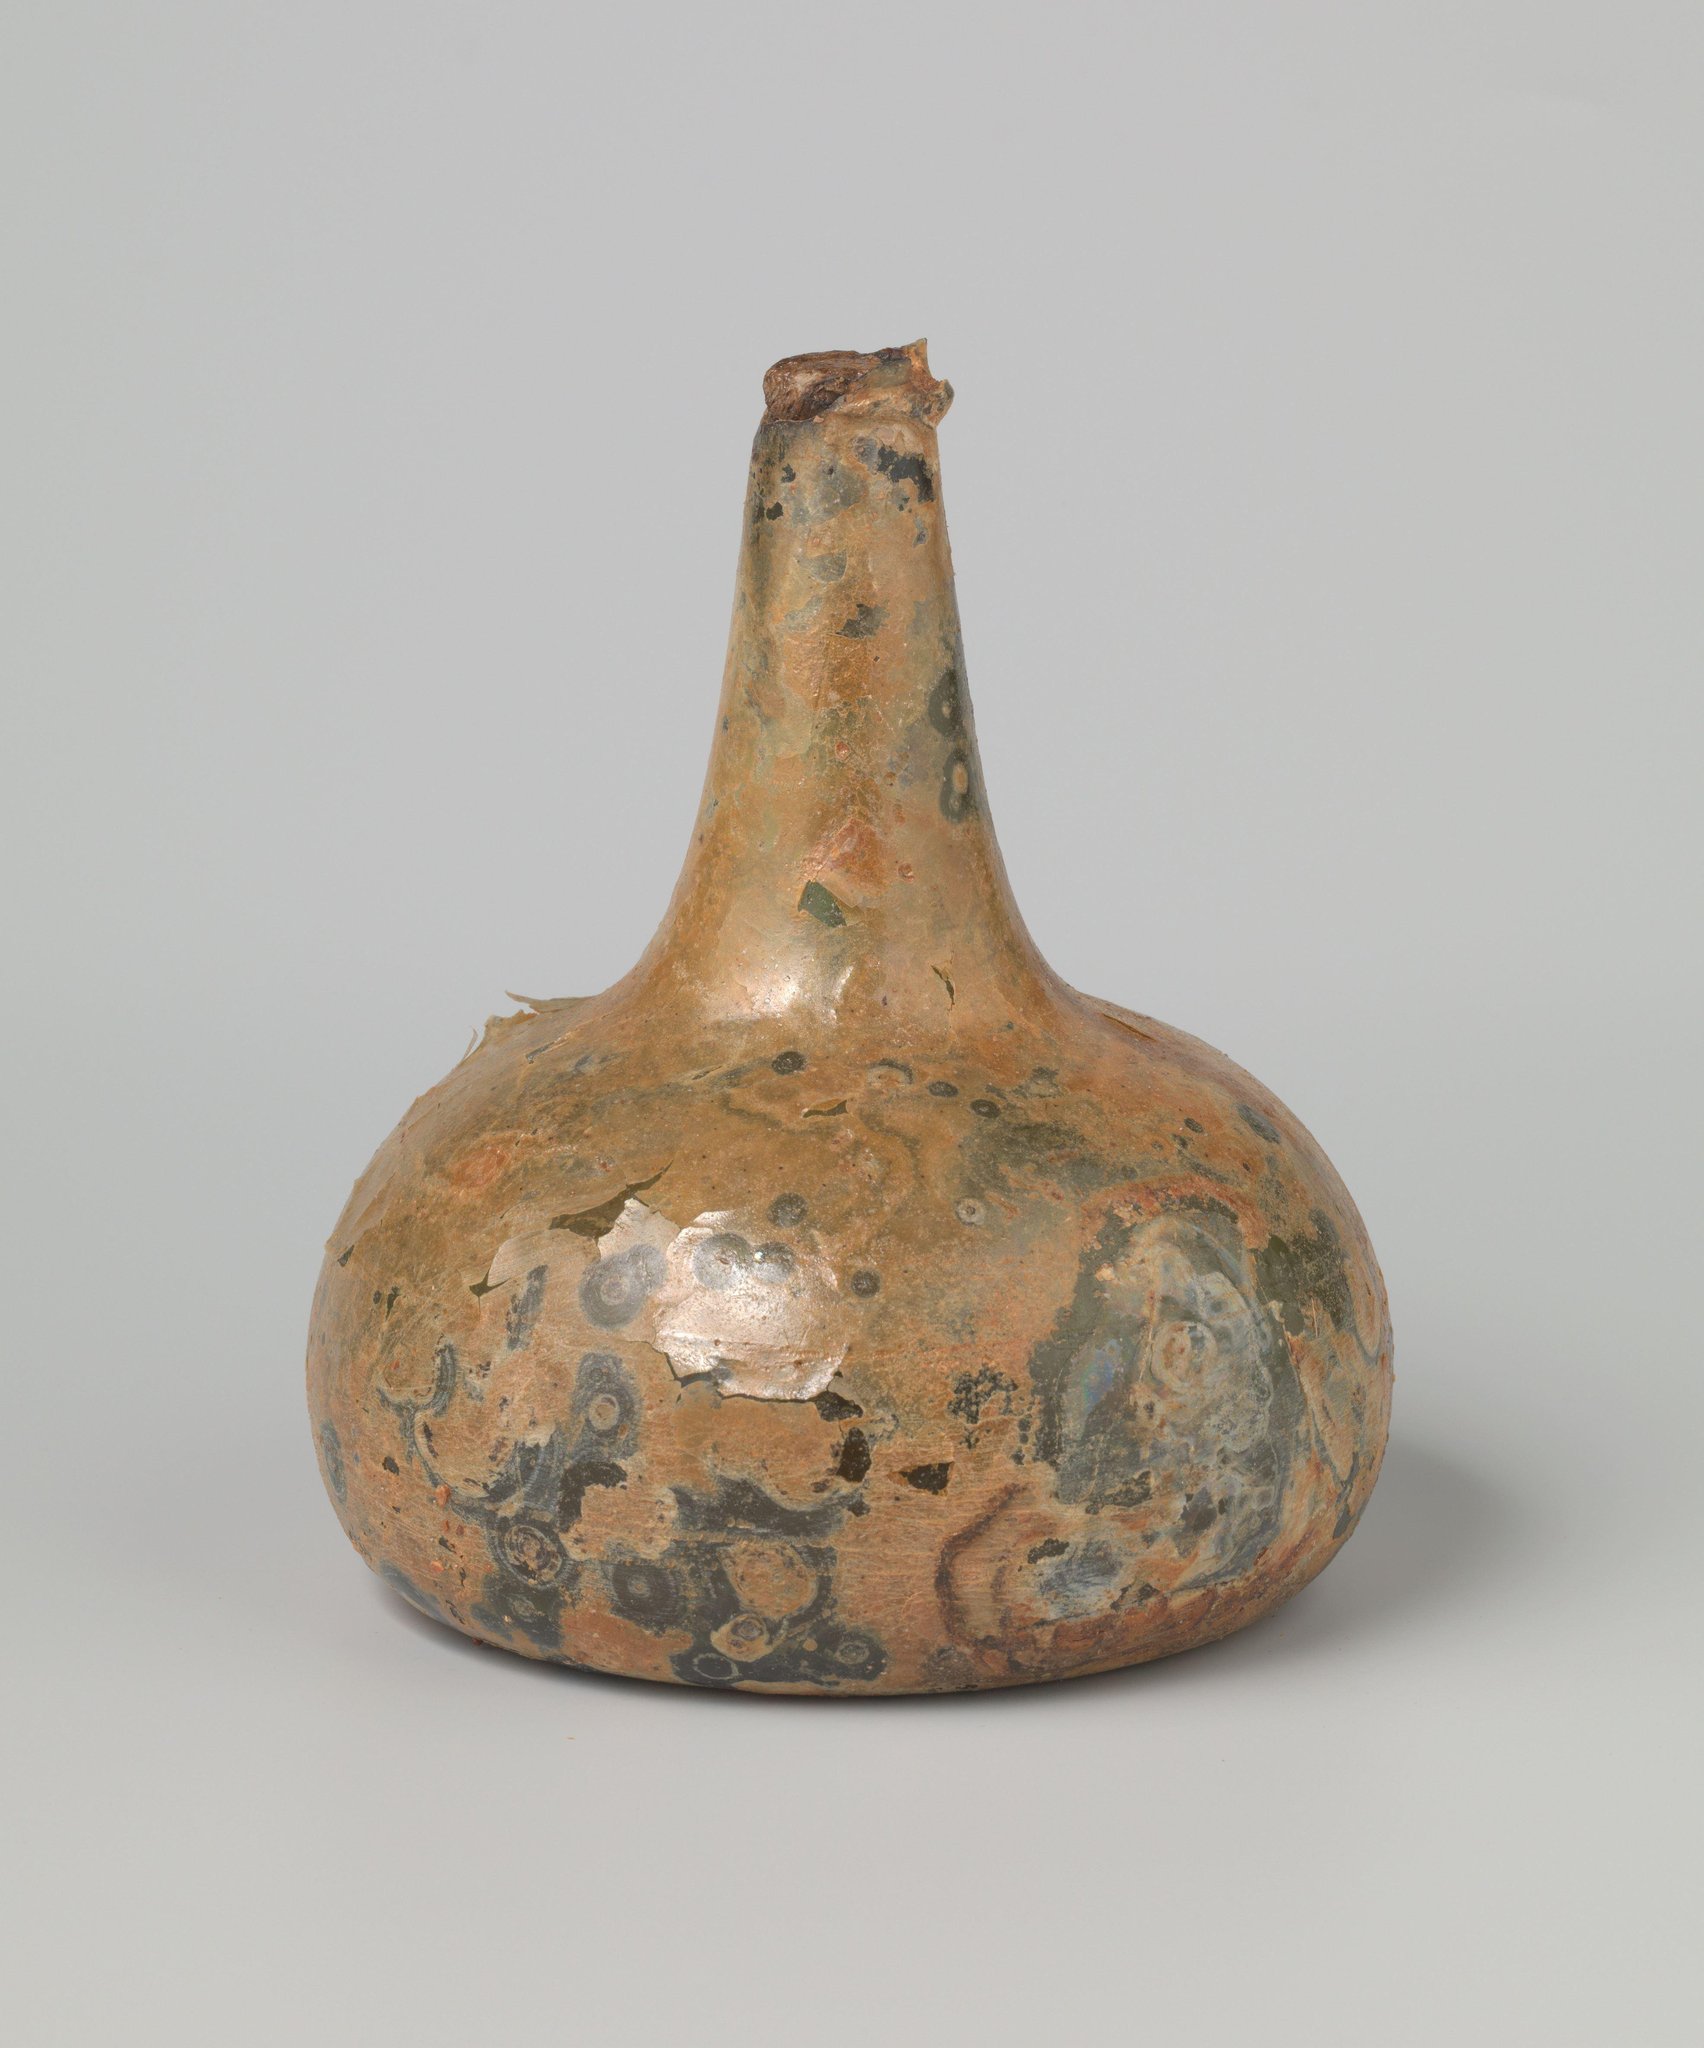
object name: wine bottle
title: Wijnfles met kurk uit het wrak van de Oost-Indiëvaarder Hollandia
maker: Anonymous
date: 1700-1743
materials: cork, glass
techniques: green glass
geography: netherlands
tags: verenigde oostindische compagnie, hollandia (schip), annet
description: Wine bottle, continental production, onion-shaped, complete; eroded, vs-string rim, tcs-kick-up.